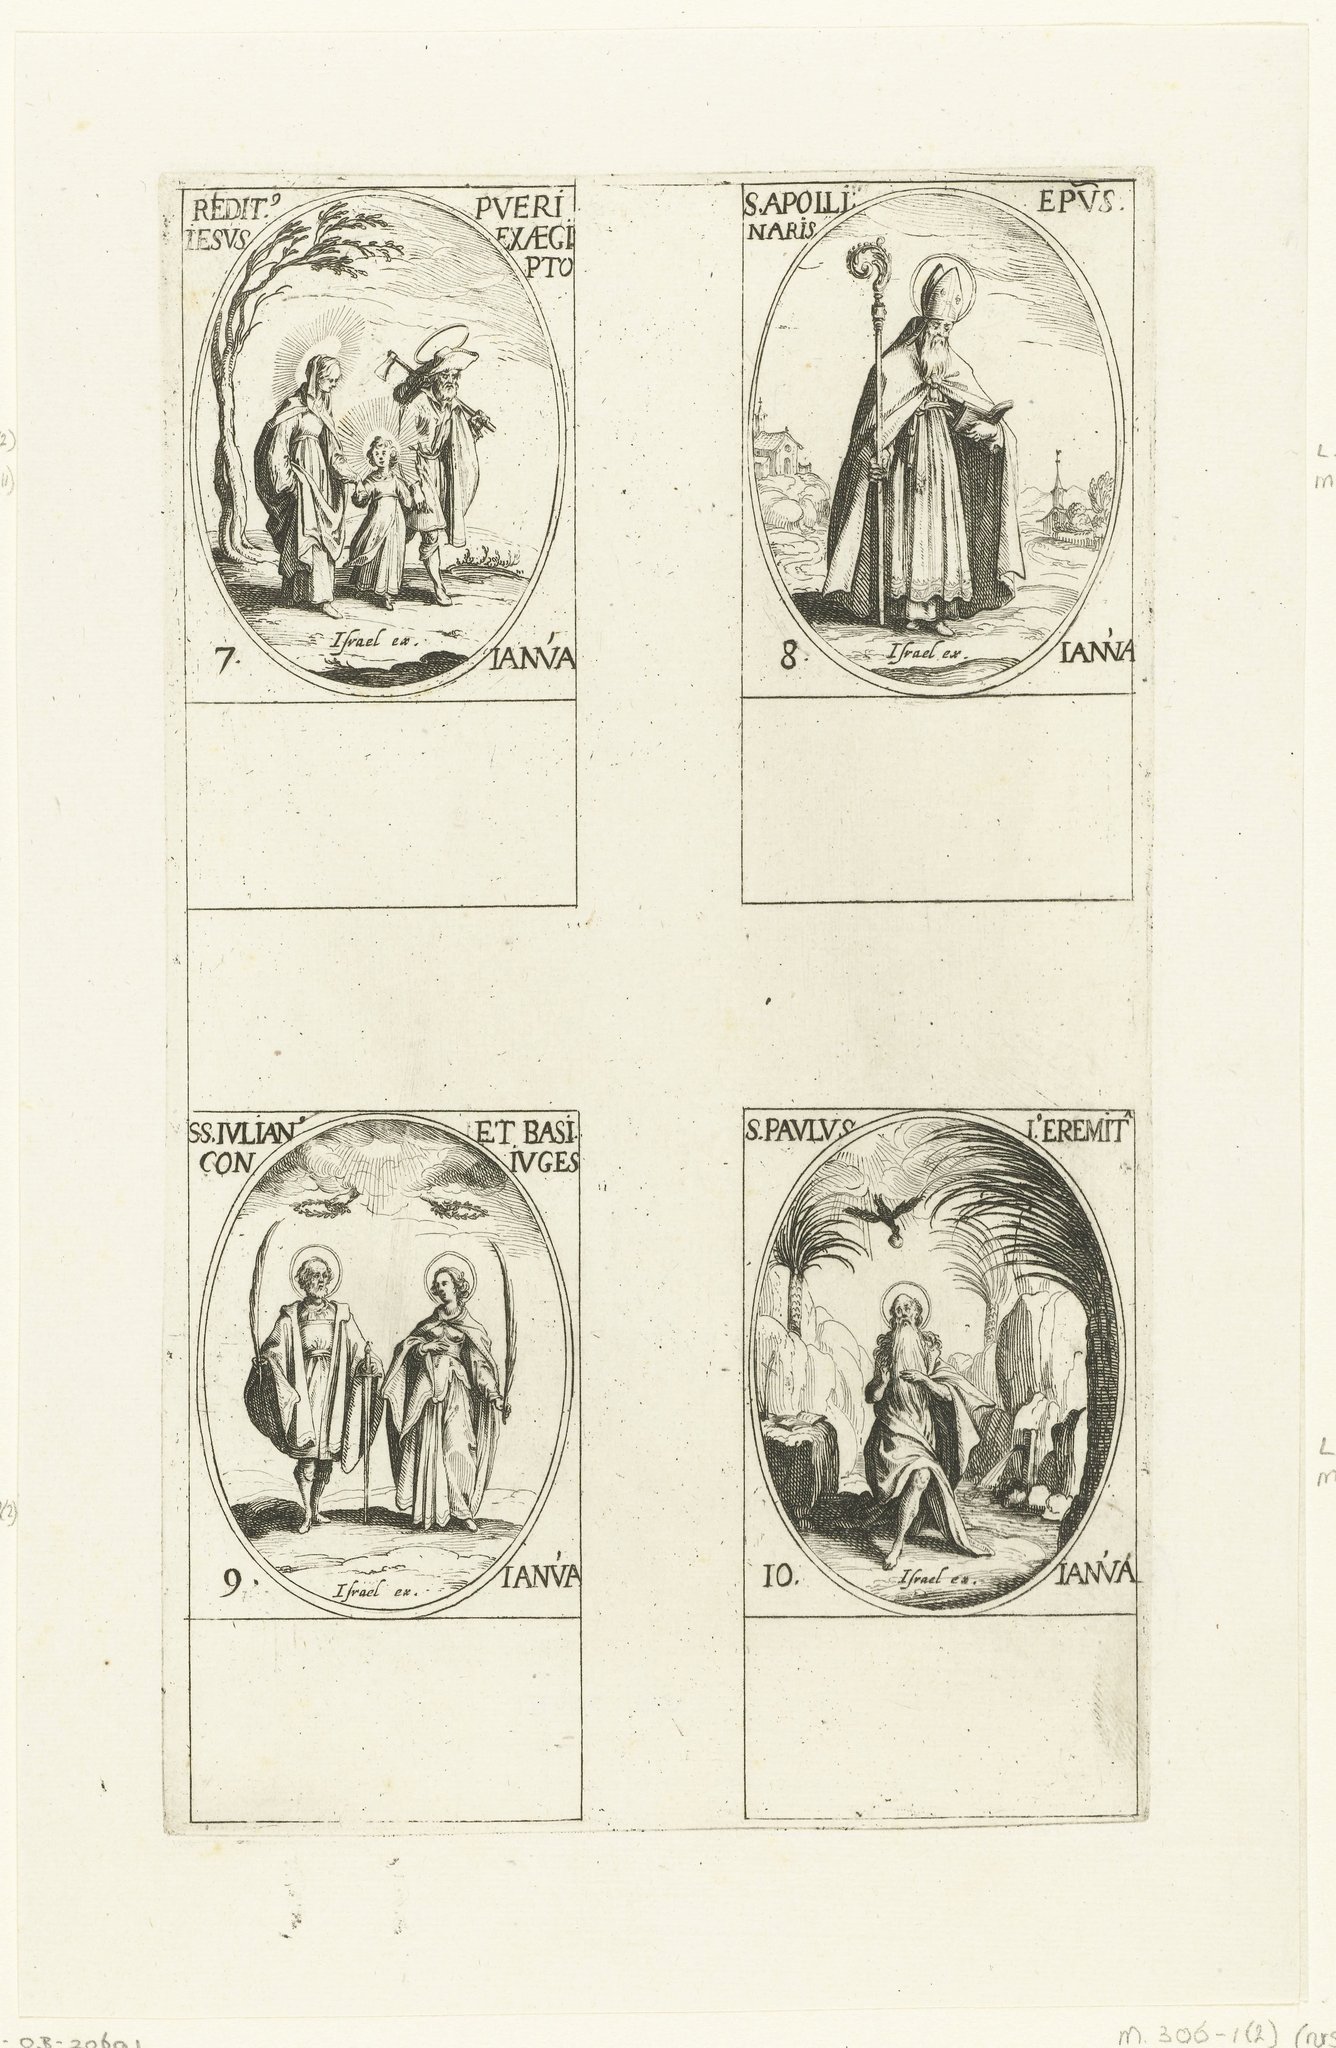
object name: print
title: Alle heiligen en de Christelijke feestdagen van het jaar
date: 1632-1636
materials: paper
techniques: etching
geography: paris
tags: the flight into egypt: mary, joseph, the child (and sometimes others) on their way; mary usually riding on an ass, st. paul the hermit in the desert, with a long beard and wearing a loincloth of woven palm-leaves, is fed with bread by a raven, female saints (with name), male saints (with name)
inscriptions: collector's mark: Lugt 240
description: Blad met vier ovale voorstellingen, elk met opschrift en datum in het Latijn: linksboven Maria onderweg met Jozef en de kleine Christus, rechtsboven de Heilige Apollinaris Claudius staand in een landschap, linksonder de Heilige Julianus en de Heilige Basilissa naast elkaar, rechtsonder de heilige Paulus de Kluizenaar die van een raaf brood ontvangt. Deze prent is onderdeel van een serie prenten met voorstellingen van de heiligen en de christelijke feestdagen van het jaar. Er zijn steeds vier scènes van één plaat op één blad gedrukt. Inclusief bijbehorend titelblad en frontispice gaat het in totaal om 124 platen (490 voorstellingen). De drie platen met de laatste 12 scènes (de veranderlijke christelijke feestdagen) zijn in de derde staat versneden tot 12 kleine plaatjes, en met een apart titelblad uitgegeven.